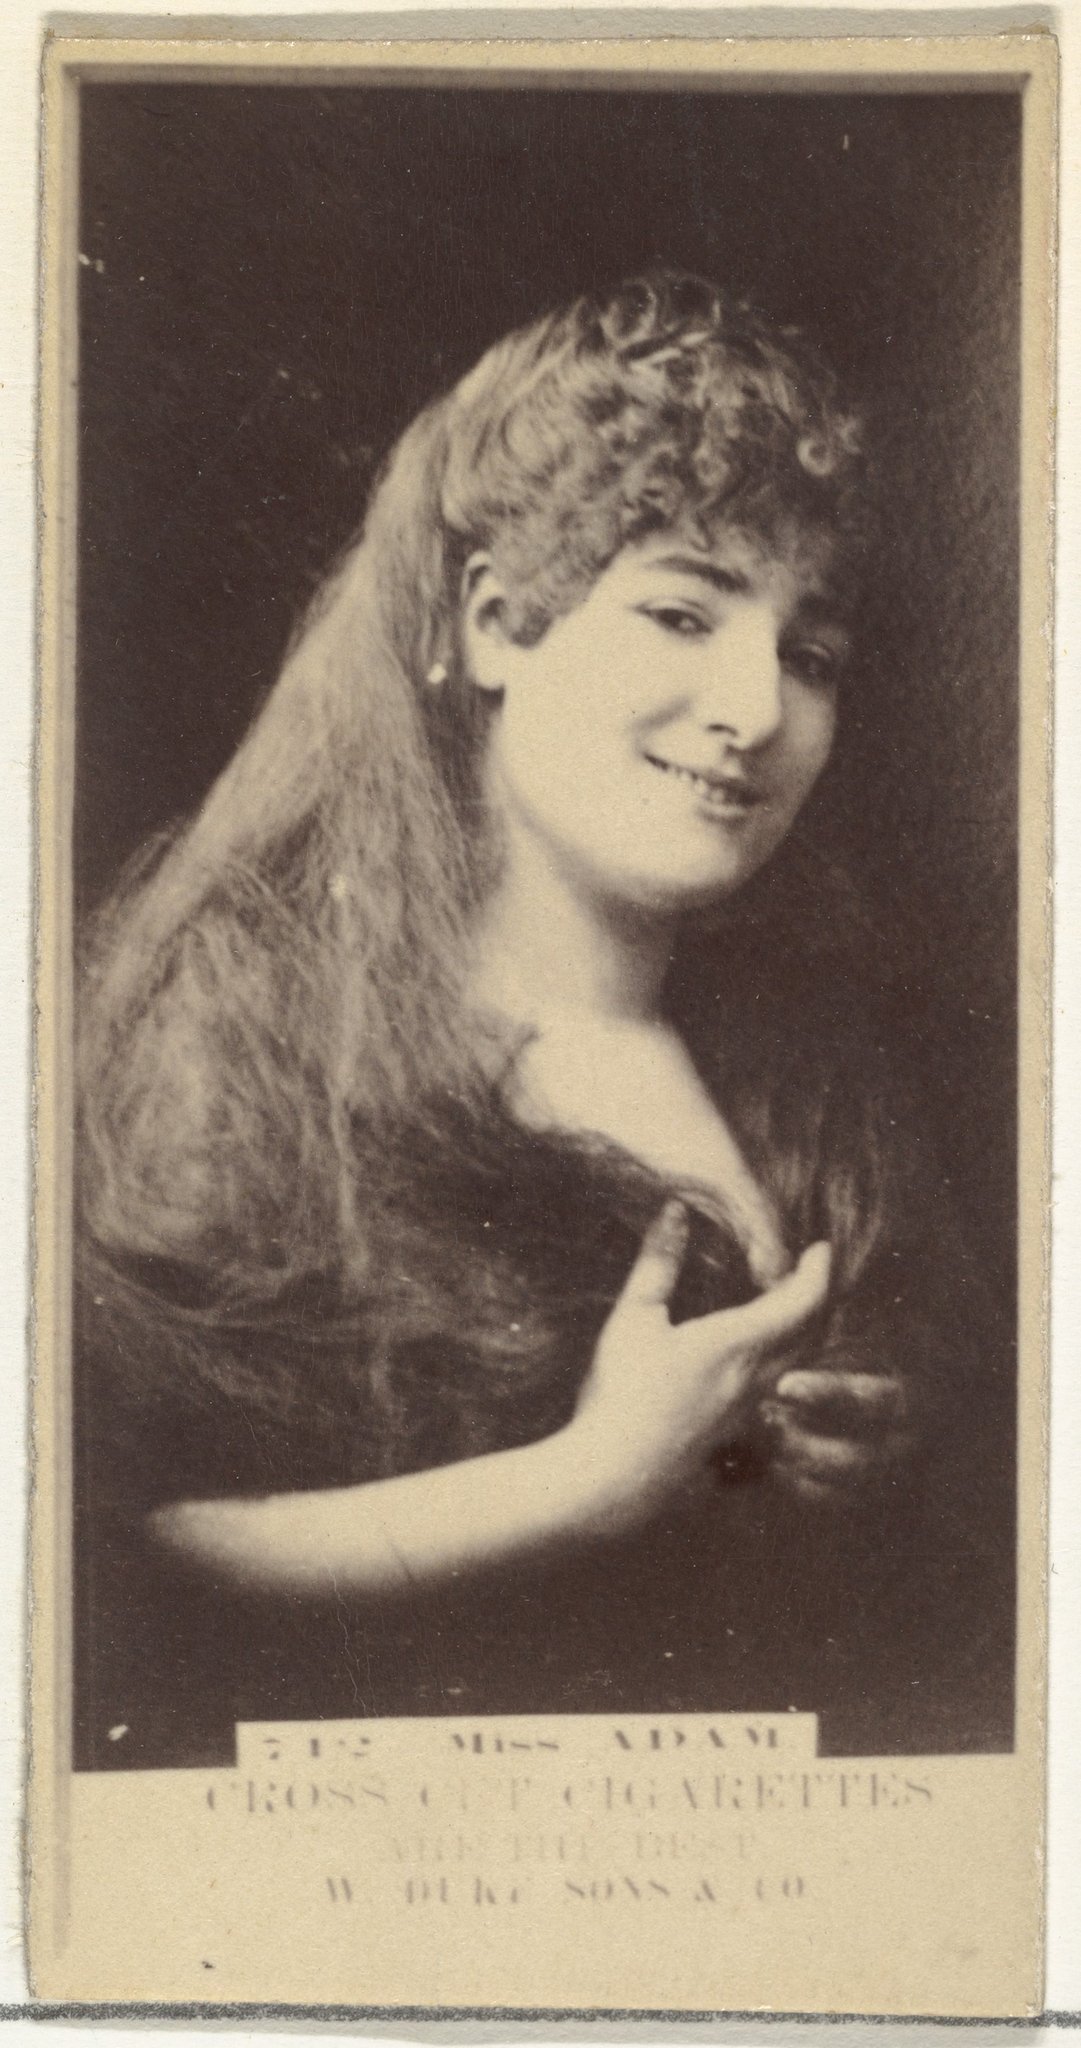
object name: photograph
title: Miss Adam, from the Actors and Actresses series (N145-3) issued by Duke Sons & Co. to promote Cross Cut Cigarettes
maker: w. duke, sons & co.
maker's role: publisher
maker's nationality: american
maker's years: 1870-1920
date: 1880-1889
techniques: albumen silver print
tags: portraits,women,actresses